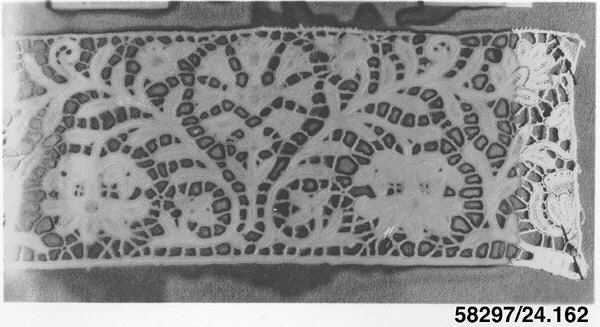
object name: strip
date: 1850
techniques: lace